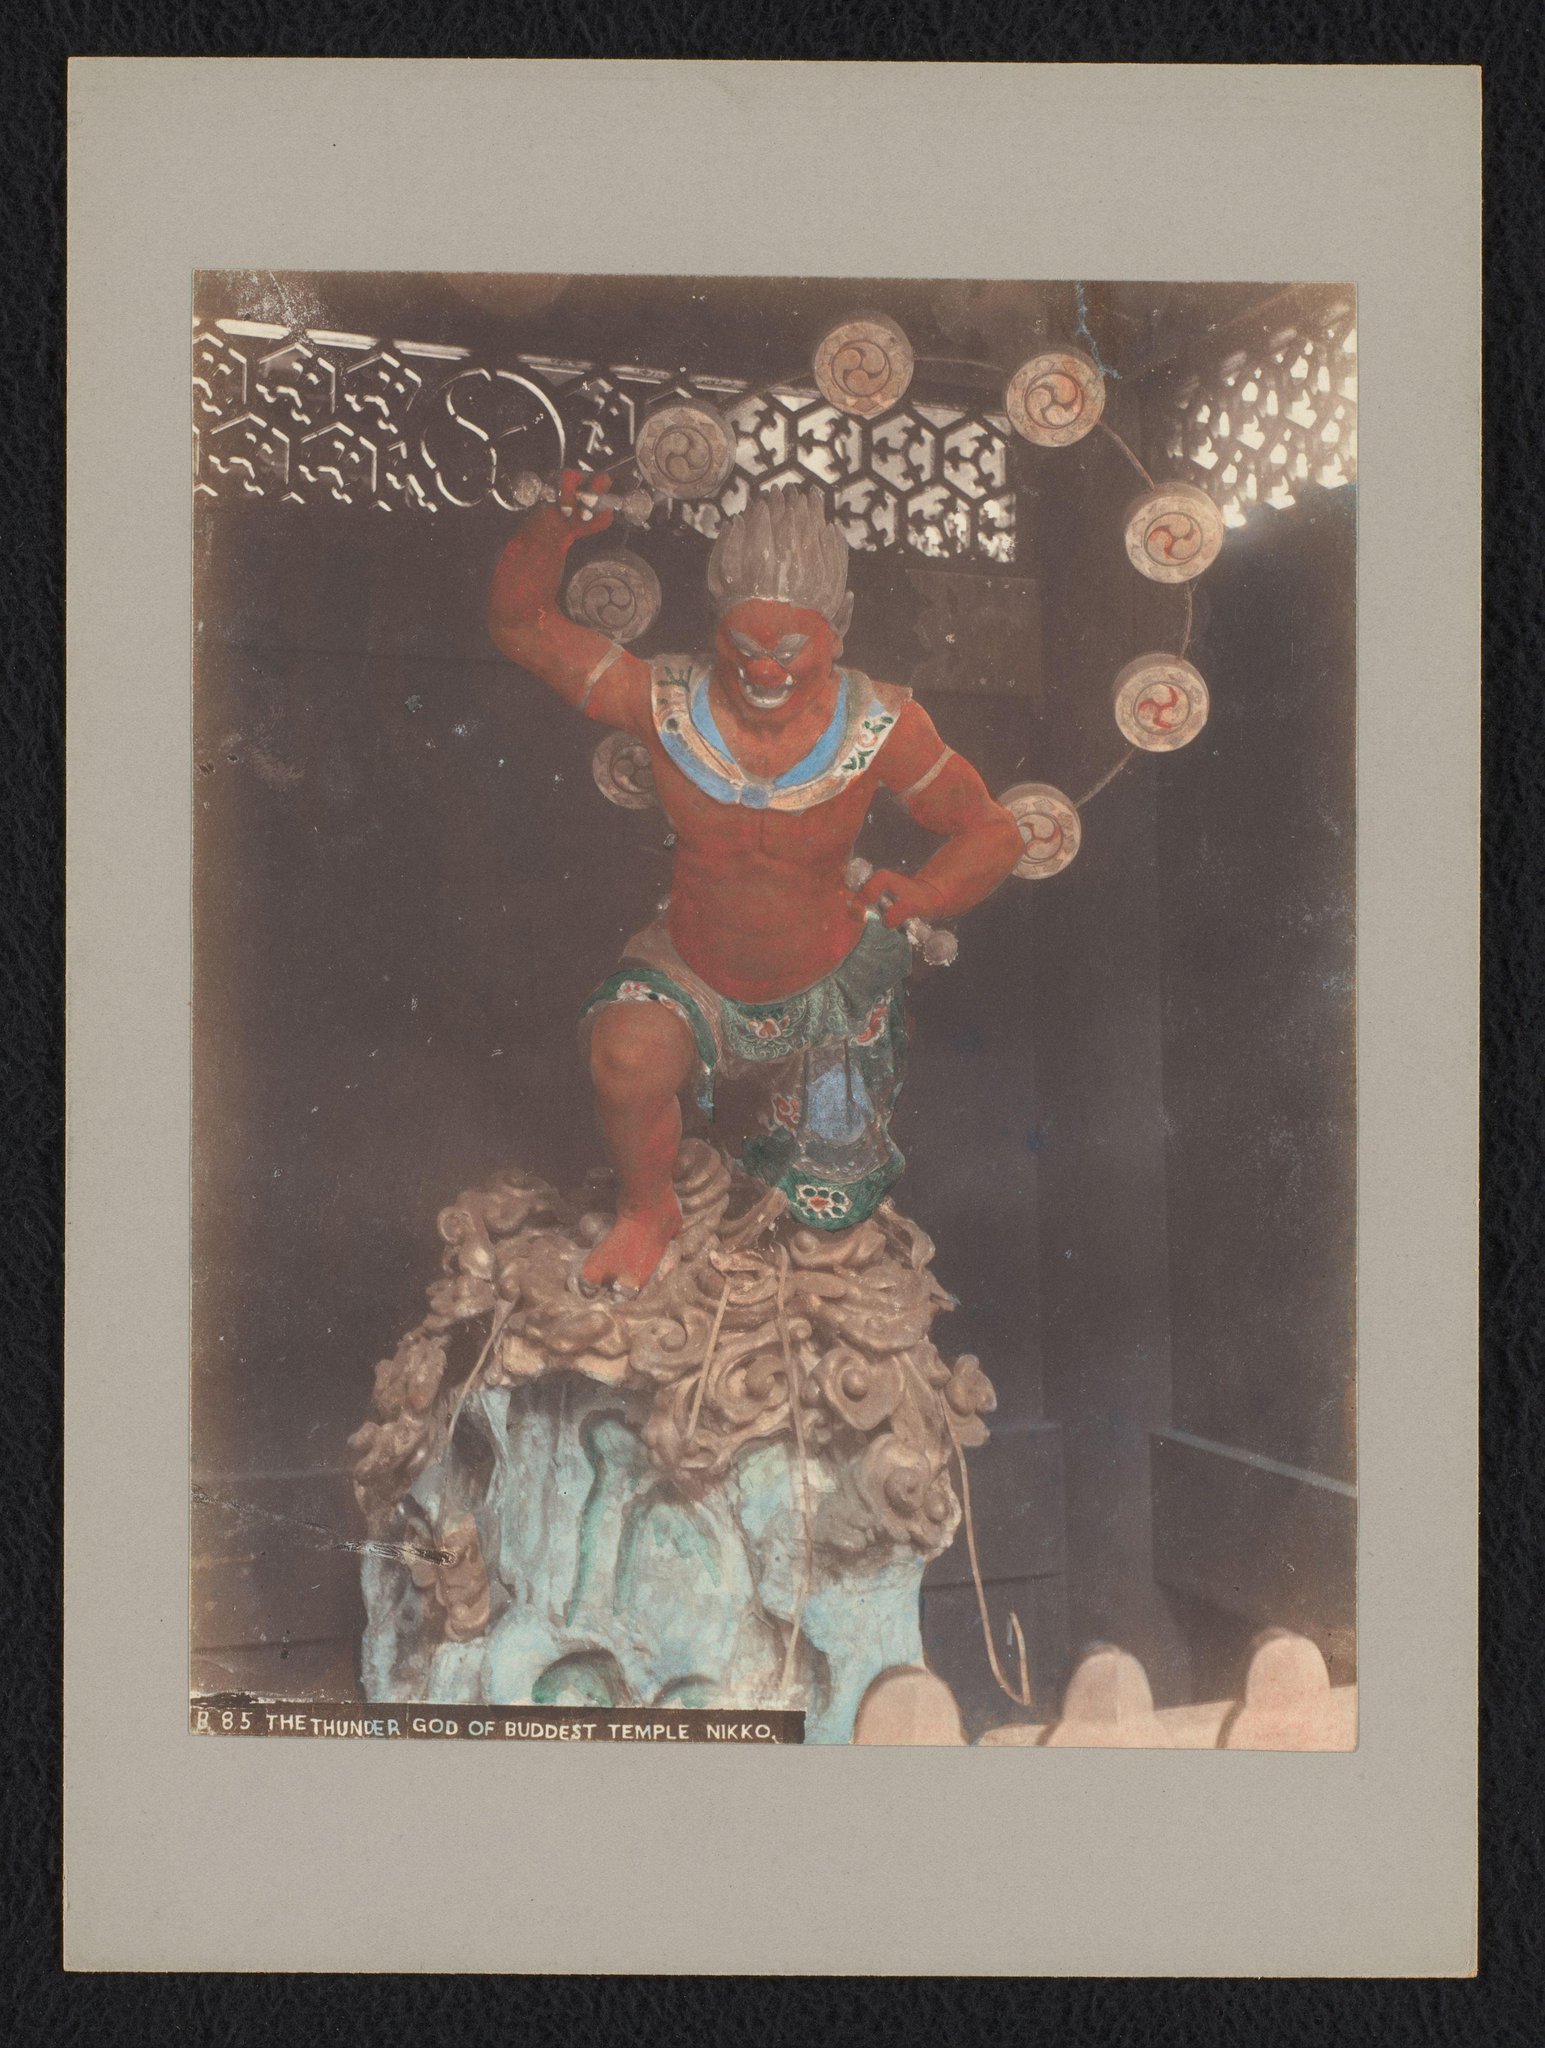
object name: photograph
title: B 85 The Thunder God of Buddest Temple Nikko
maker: Anonymous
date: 1895-1915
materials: cardboard, photographic support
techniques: salted paper print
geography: nikko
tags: nikko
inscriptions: number: ‘31.’